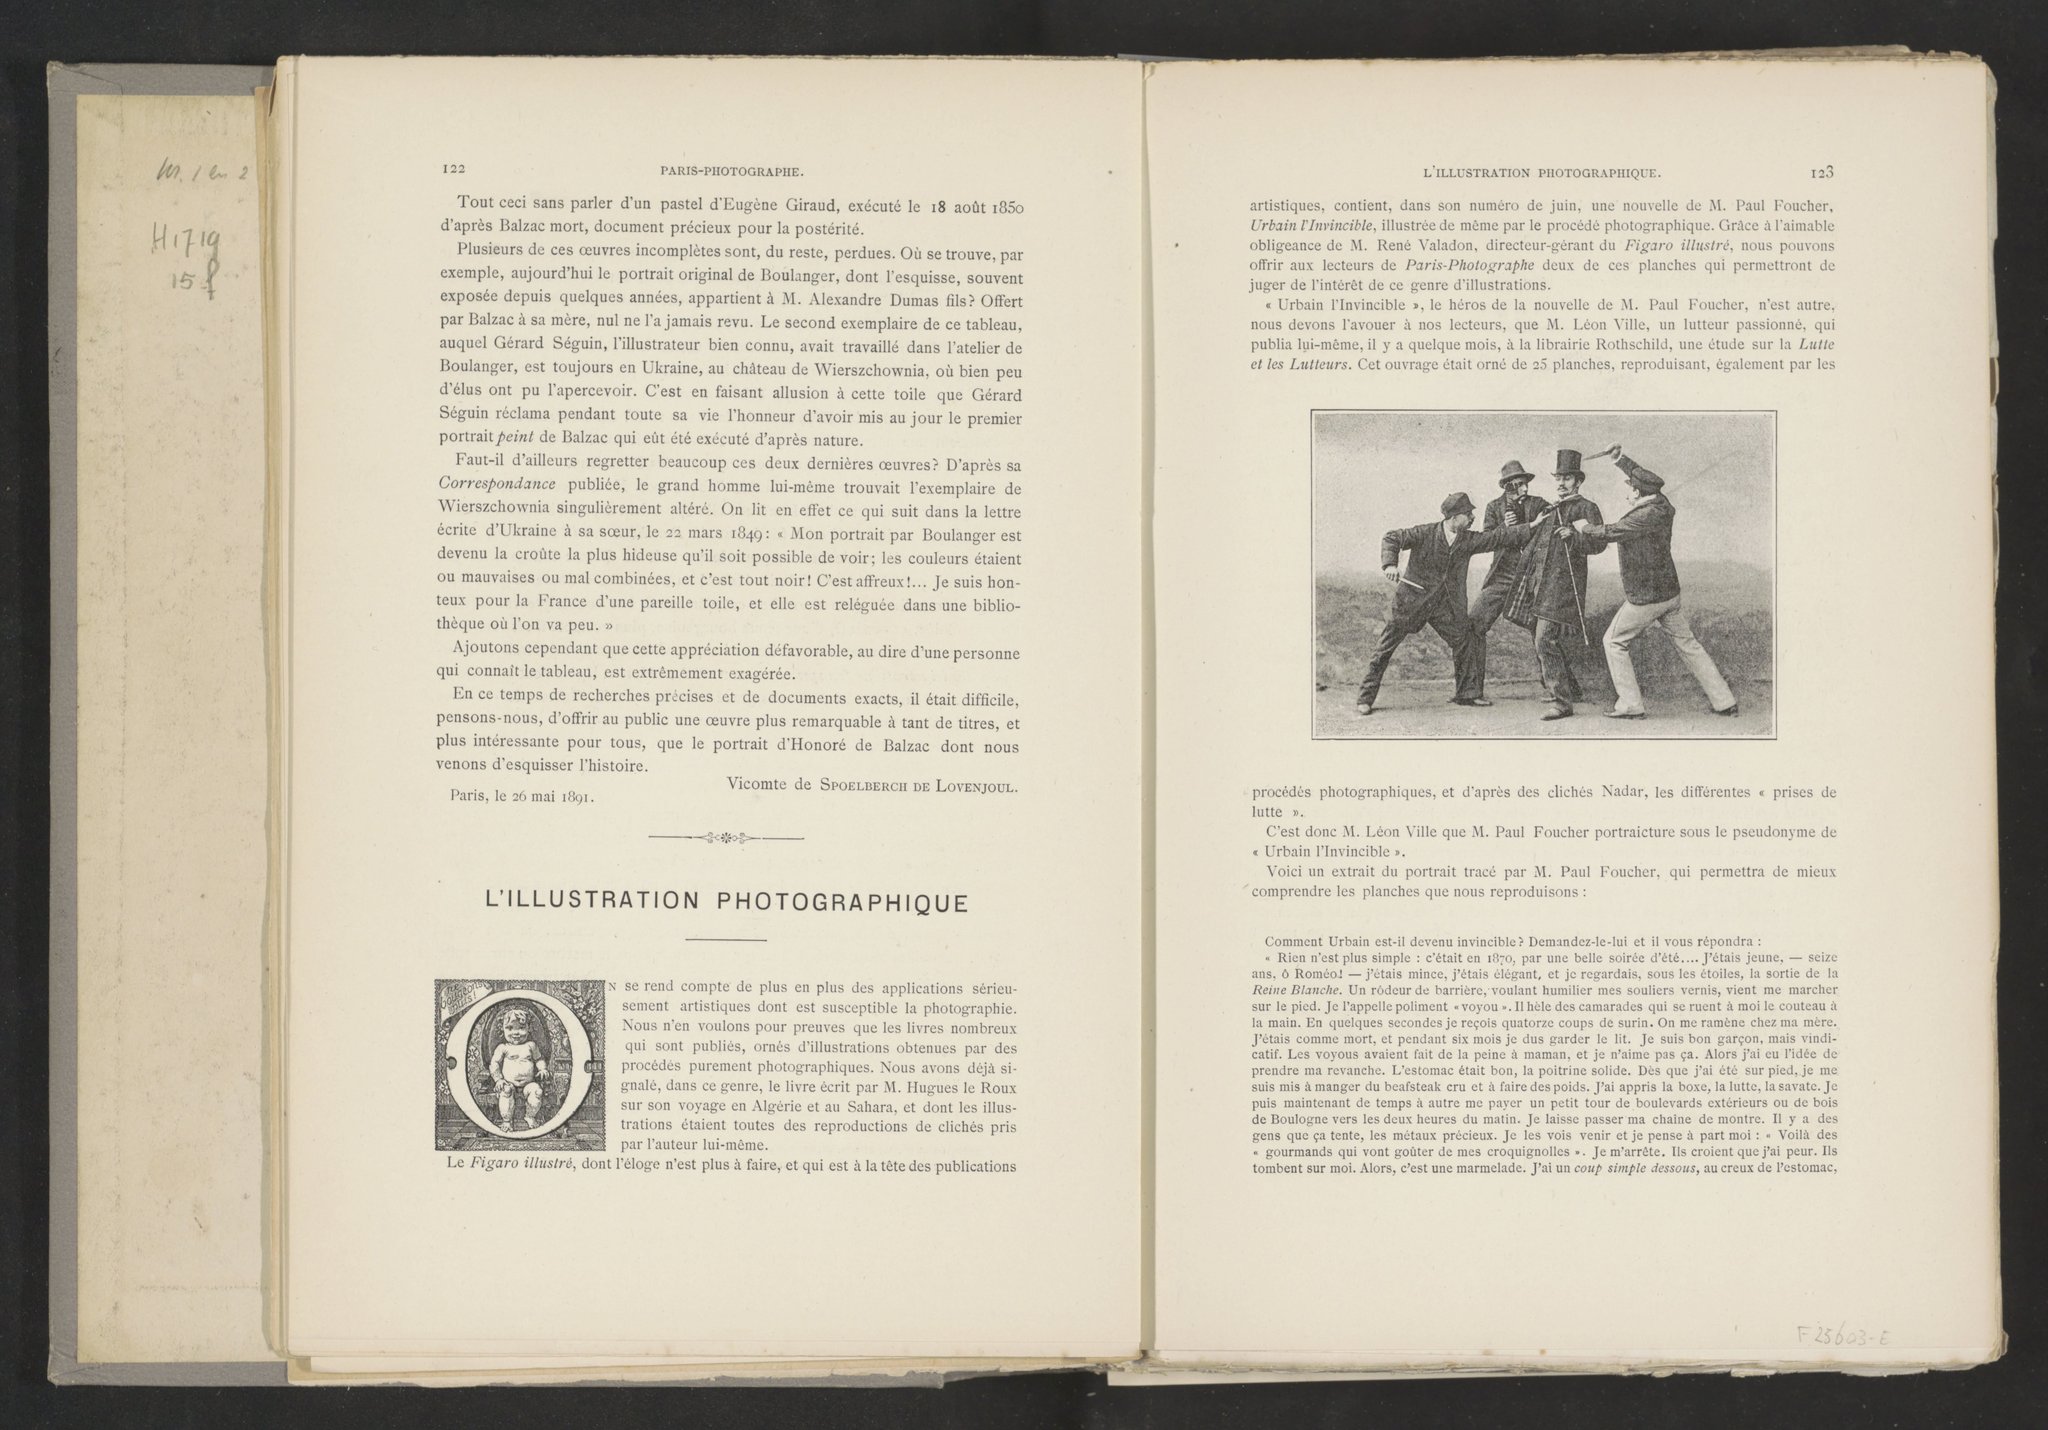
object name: photomechanical print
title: Gewapende overval op een man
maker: Anonymous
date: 1881-1891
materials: paper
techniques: autotype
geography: france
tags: robbery